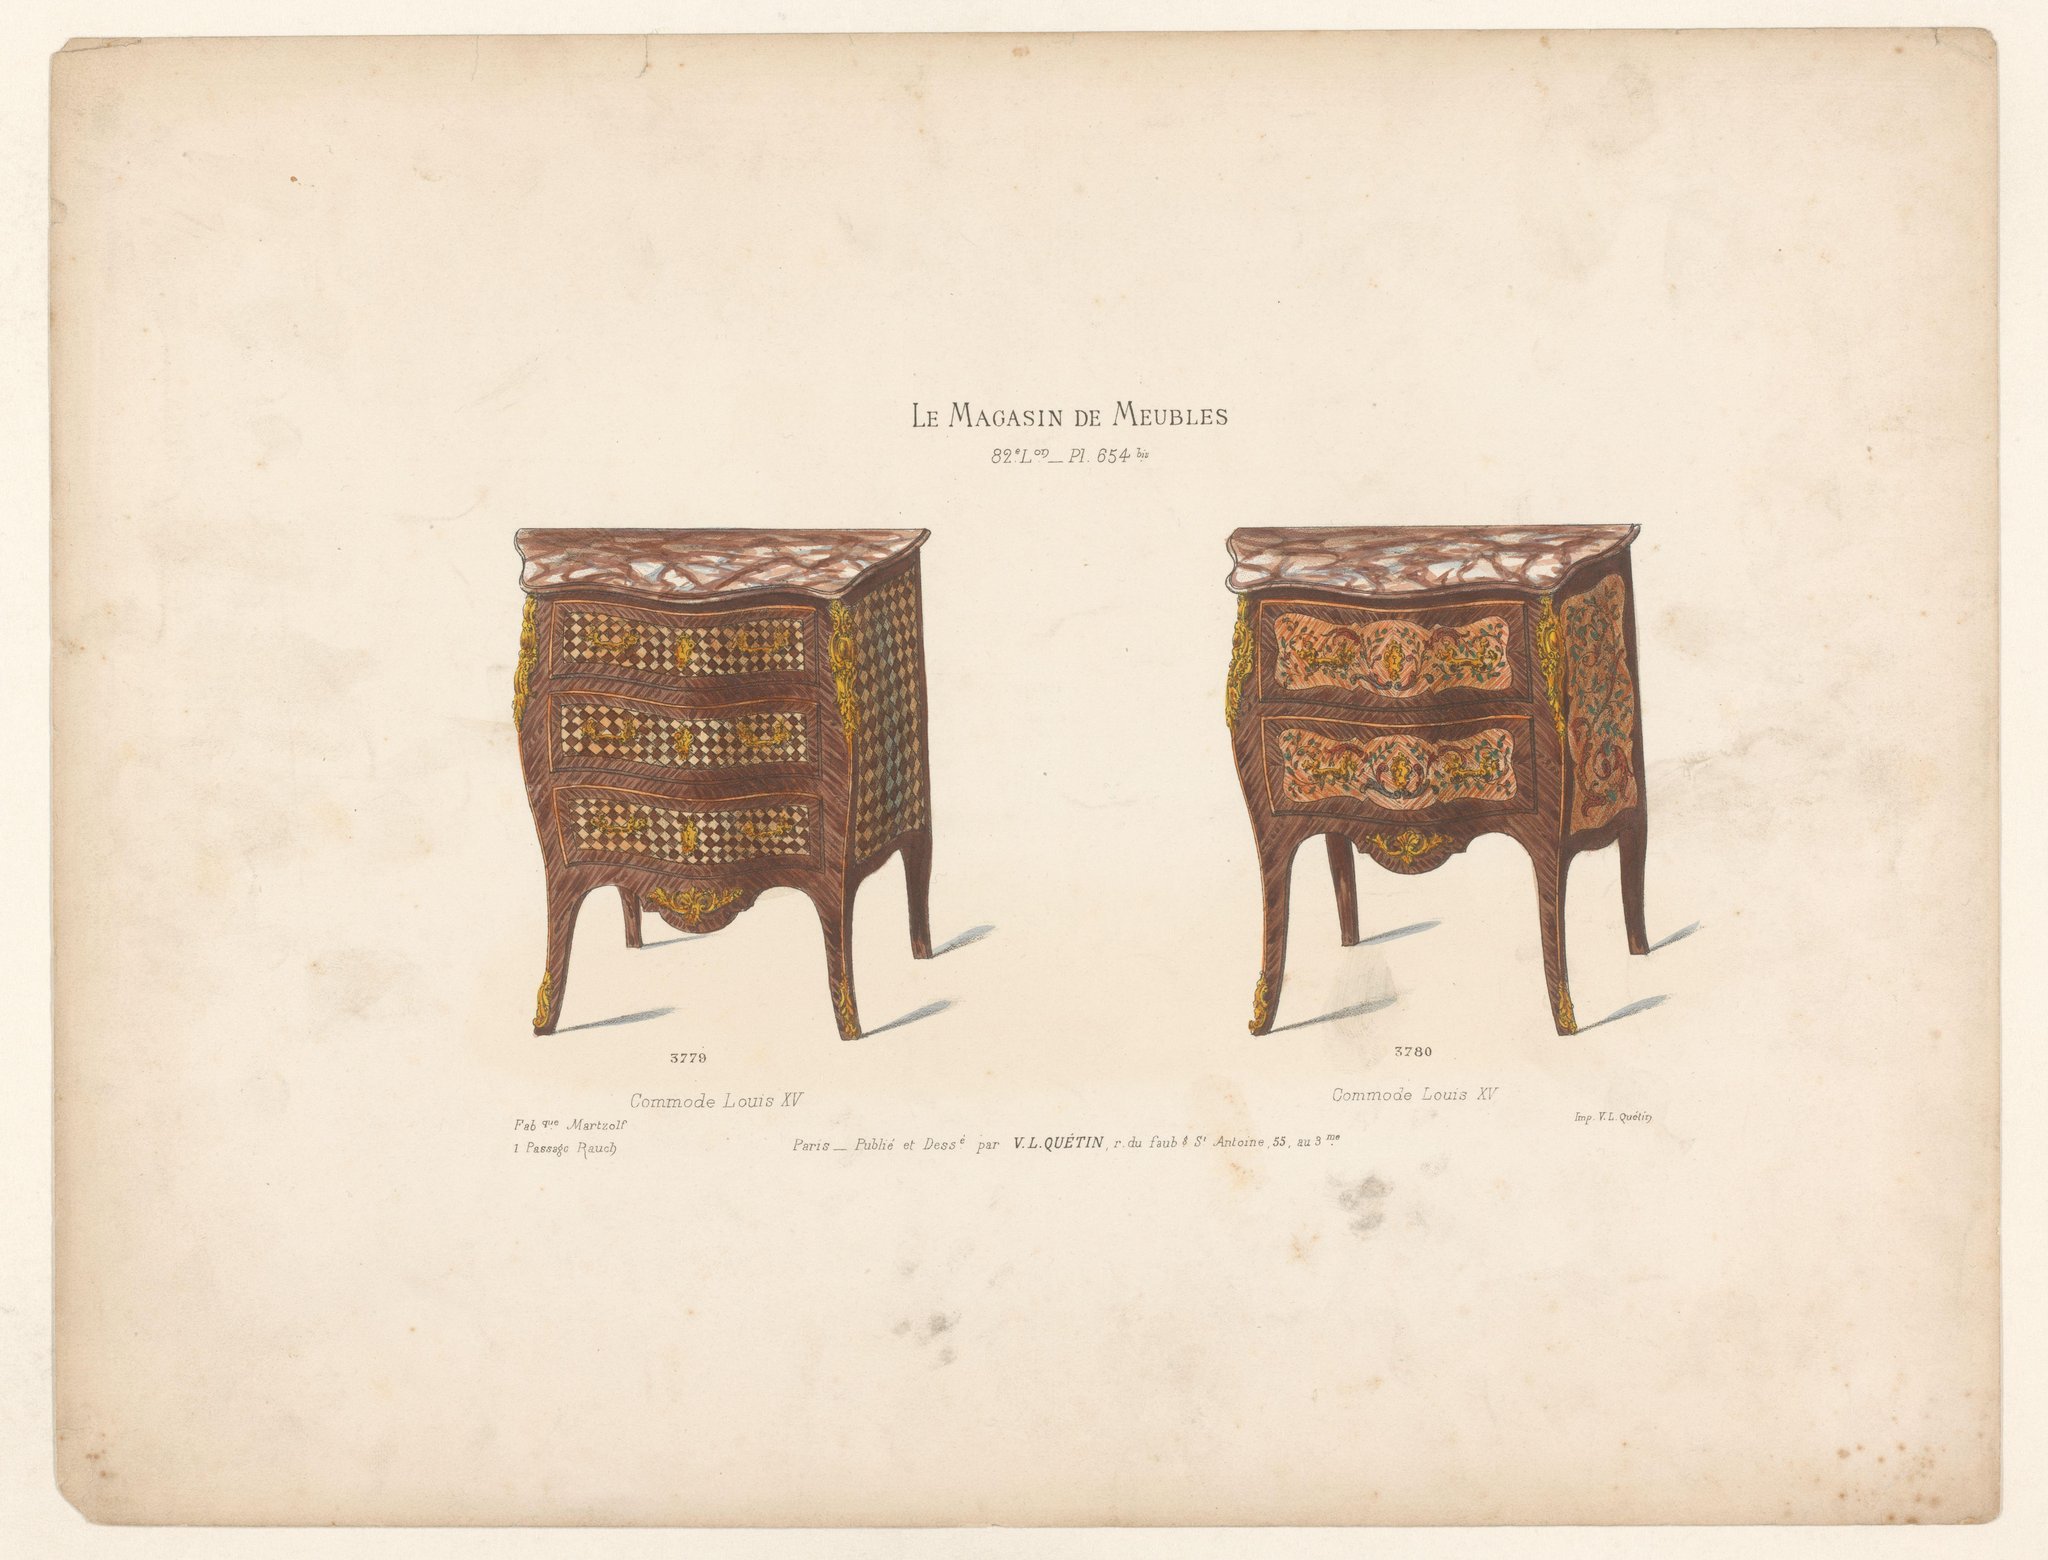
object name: print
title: Le Magasin de Meubles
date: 1878-1904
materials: paper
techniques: hand coloring, lithograph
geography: paris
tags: furniture for storage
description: Twee commodes in de Lodewijk XV-stijl. Prent uit 82e Livraison.